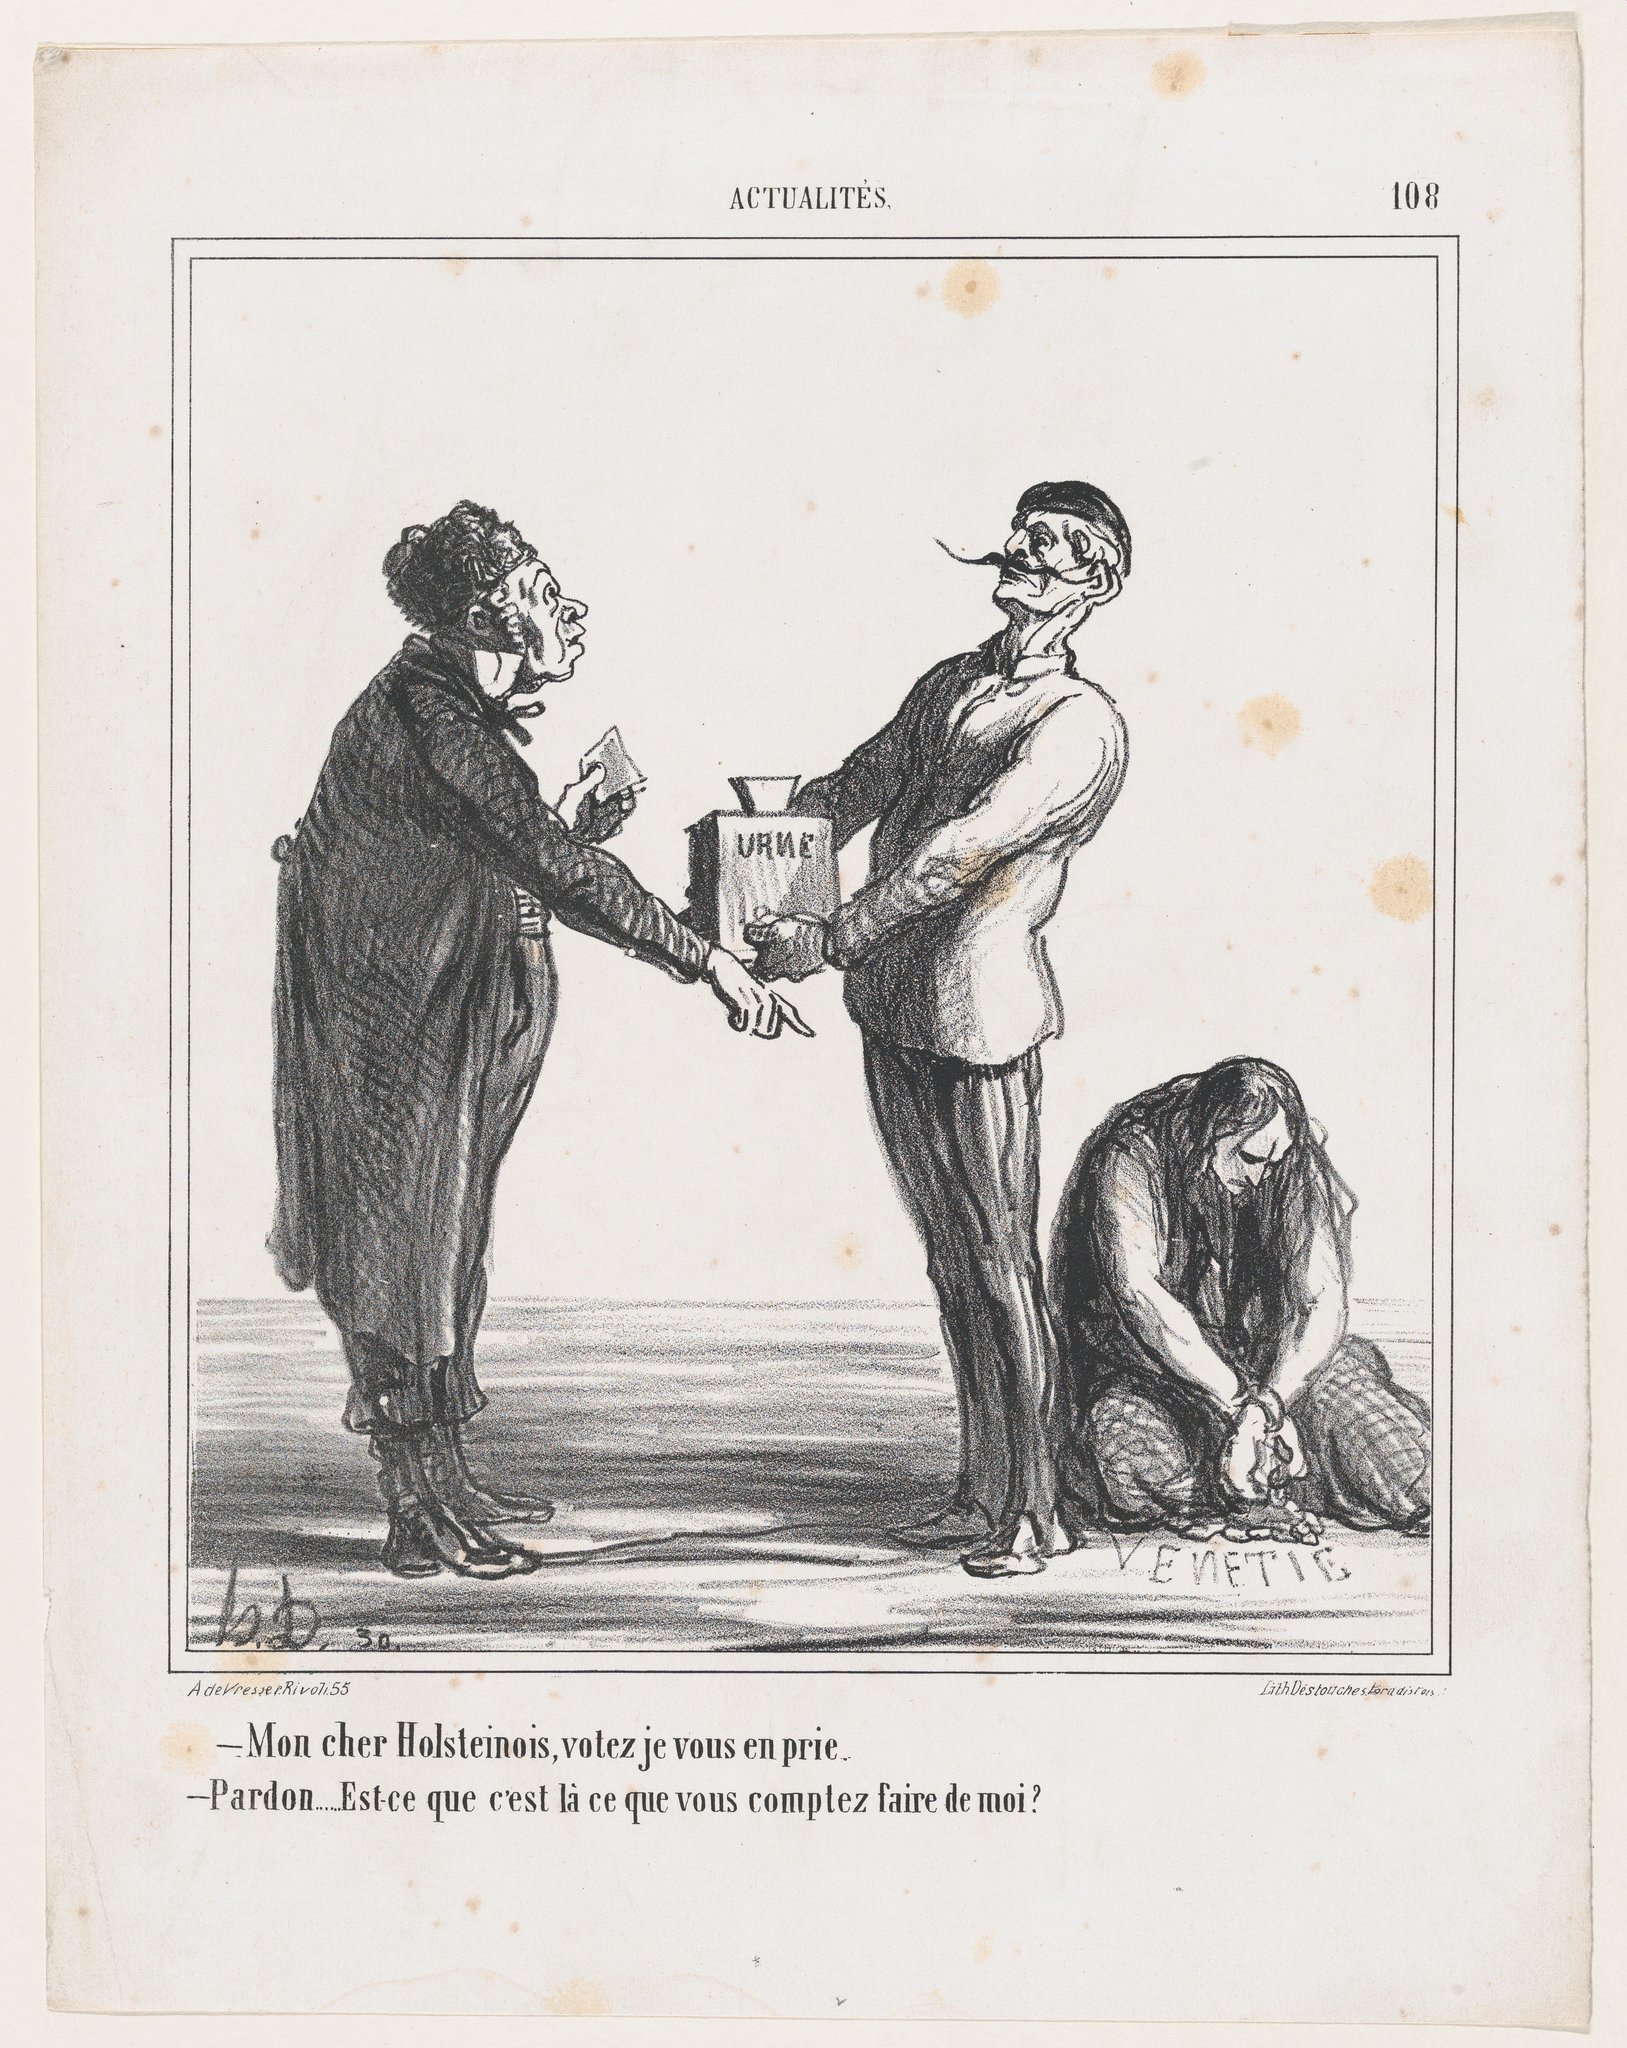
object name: print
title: – My dear Holsteiner, I urge you to vote. – Pardon me, but am I going to end the same way as this one?, from "News of the day"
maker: honoré daumier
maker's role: artist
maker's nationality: french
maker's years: 1808-1879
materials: paper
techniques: lithograph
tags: satire,elections,men,women